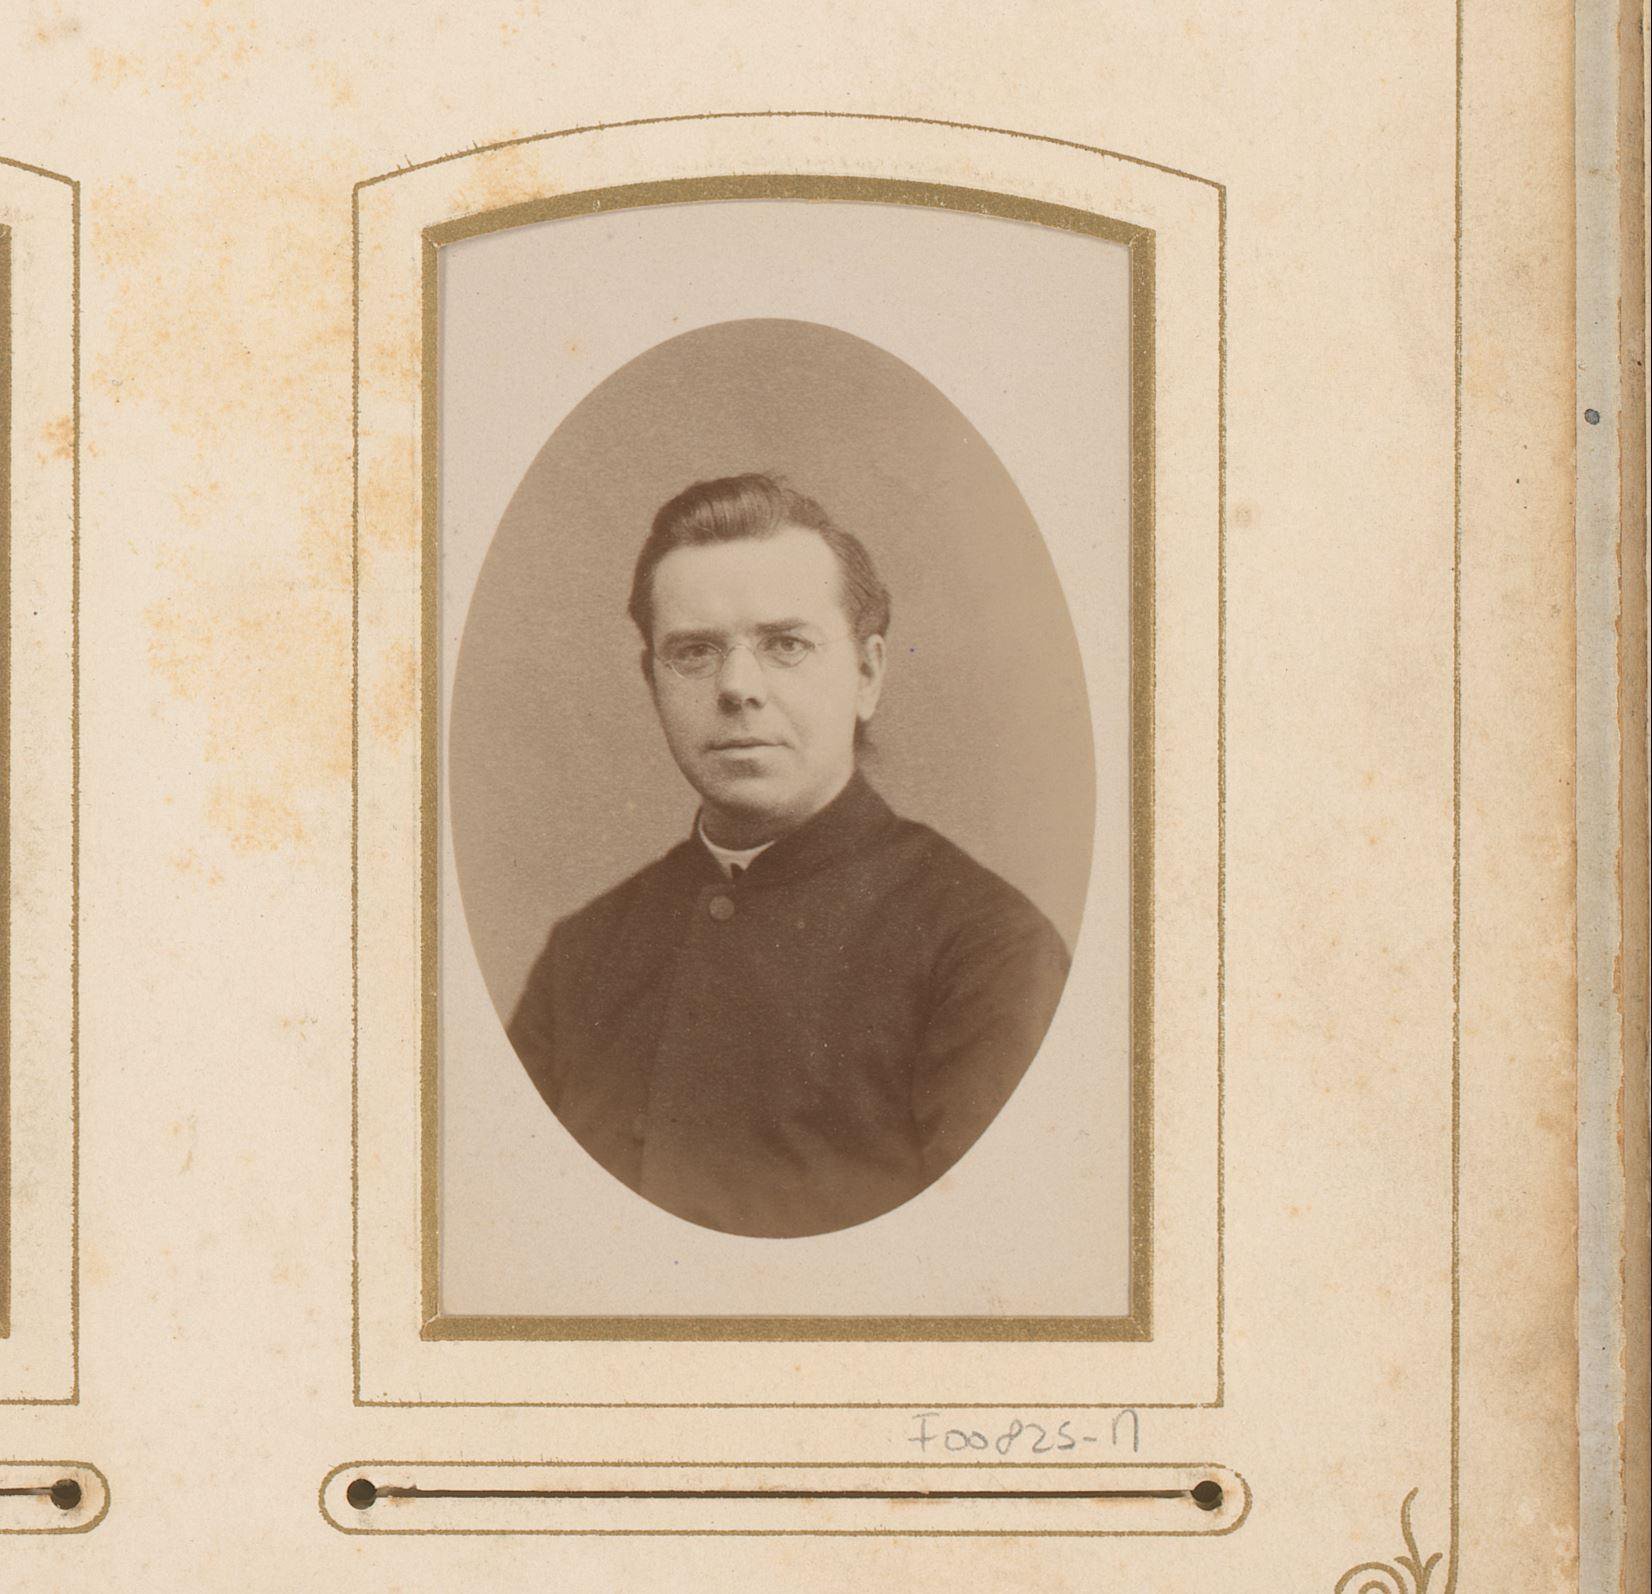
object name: album leaf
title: Portret van een geestelijke met bril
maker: louis robert werner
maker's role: fotograaf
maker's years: 1834-1896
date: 1866-1896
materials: cardboard, photographic support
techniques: albumen print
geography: amsterdam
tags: eyeglasses, spectacles, theologian, historical persons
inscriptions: inscription: ‘L. R. Werner/ voorheen P. Carstensen/ Amsterdam/ Nieuwendijk H 150./ Nabestellingen en Vergrotingen,/ ook van anderen Portretten, kunnen iederen tijd/ geleverd worden.’